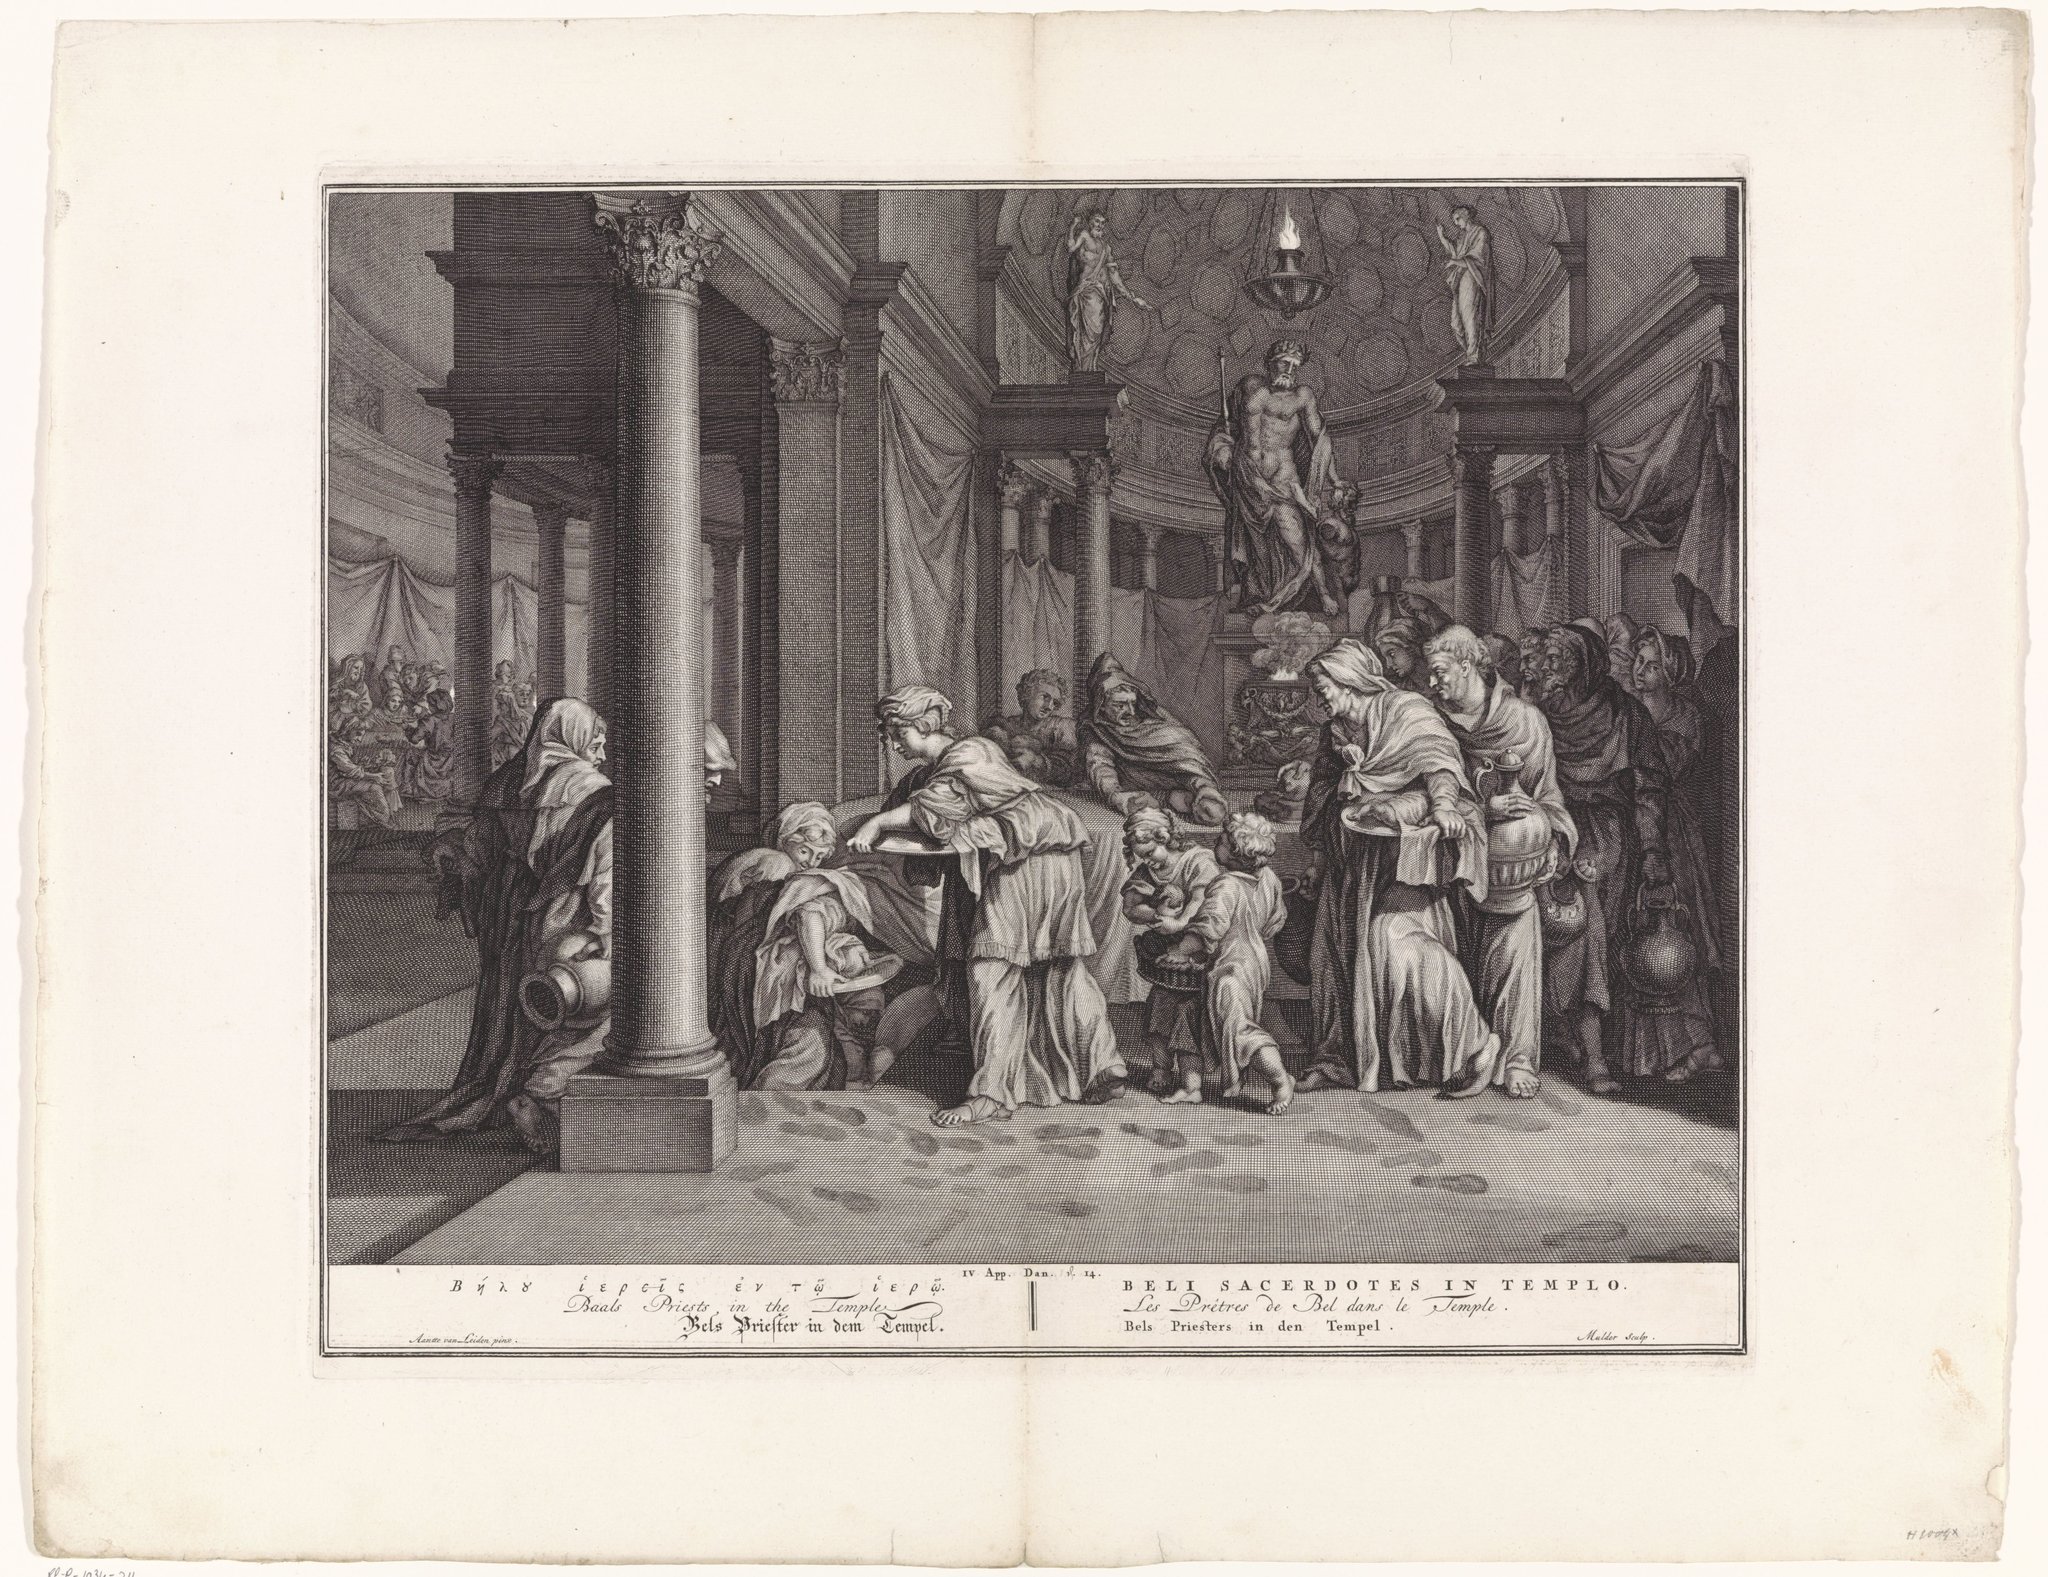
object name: print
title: Bels priesters in de tempel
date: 1720-1728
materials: paper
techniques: engraving, etching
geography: amsterdam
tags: the priests of bel, with their wives and children, enter the temple through a hidden corridor and feast on the food during the night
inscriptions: inscription: ‘Utrechts fundatie huijs’, collector's mark: Lugt 2228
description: De priesters van Bel eten het aan de god Bel geofferde voedsel. Ze komen en gaan door een geheime gang onder de tafel. Terwijl ze heimelijk het voedsel nemen, blijven hun voetstappen achter in de door Daniël op de grond gestrooide as. Onderaan in de marge een verwijzing naar de Bijbeltekst en de titel in het Grieks, Engels, Latijn, Duits, Frans en Nederlands.